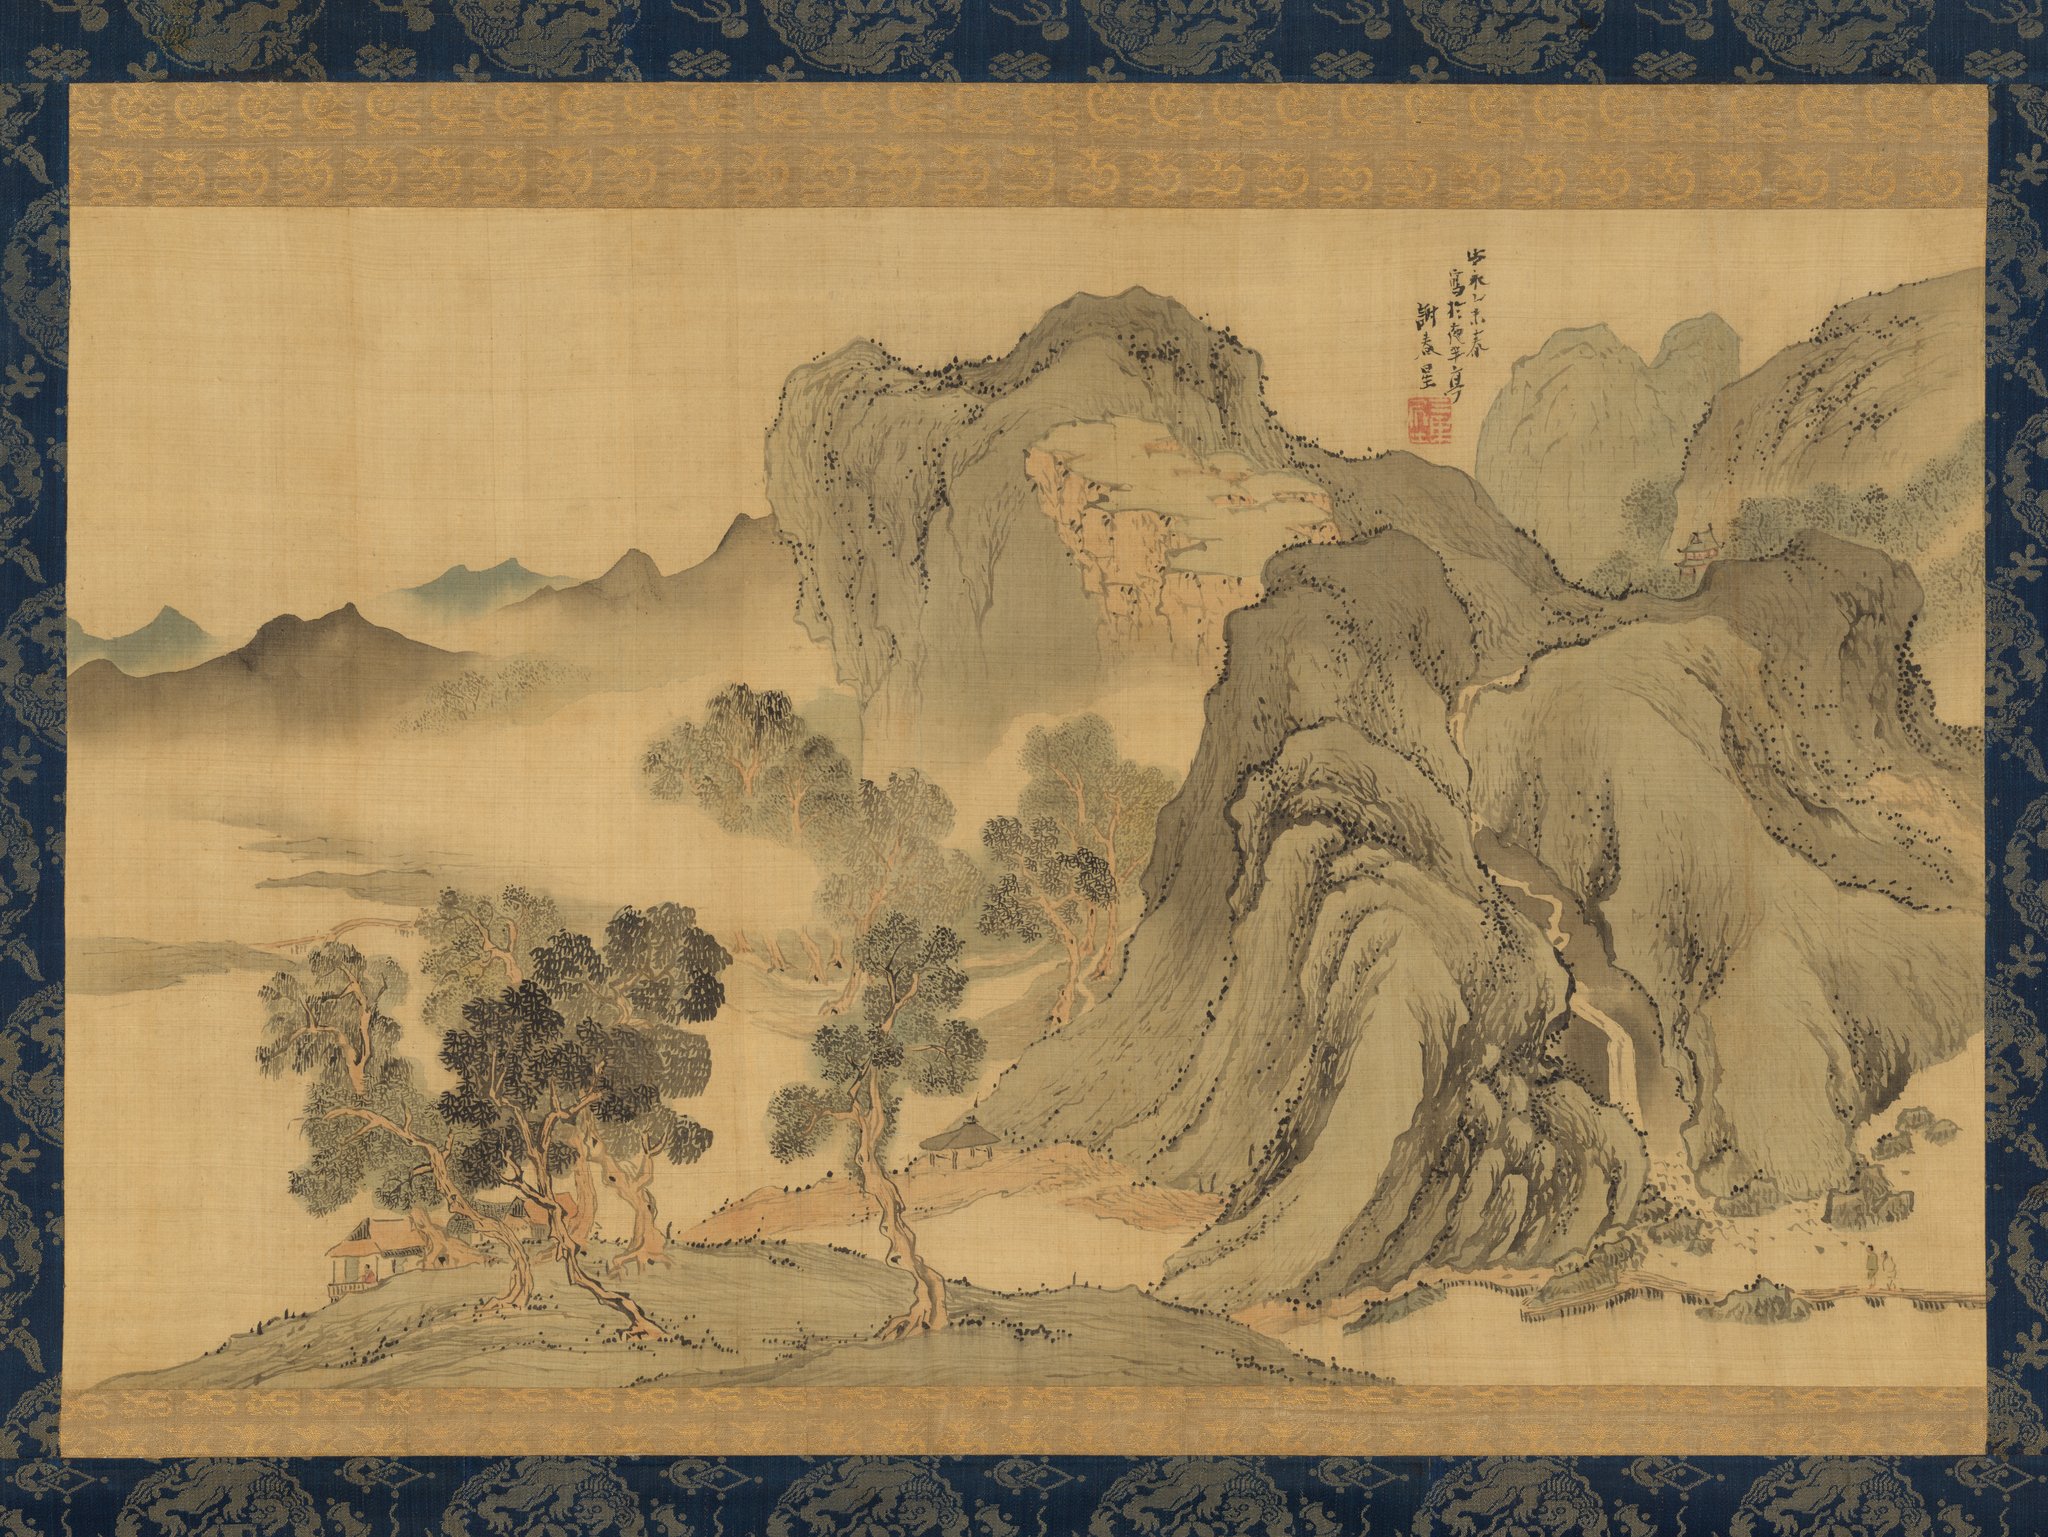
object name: hanging scroll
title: Landscape in Light Colors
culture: japanese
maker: yosa buson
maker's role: artist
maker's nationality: japanese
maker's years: 1716-1783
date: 1775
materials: ink, silk